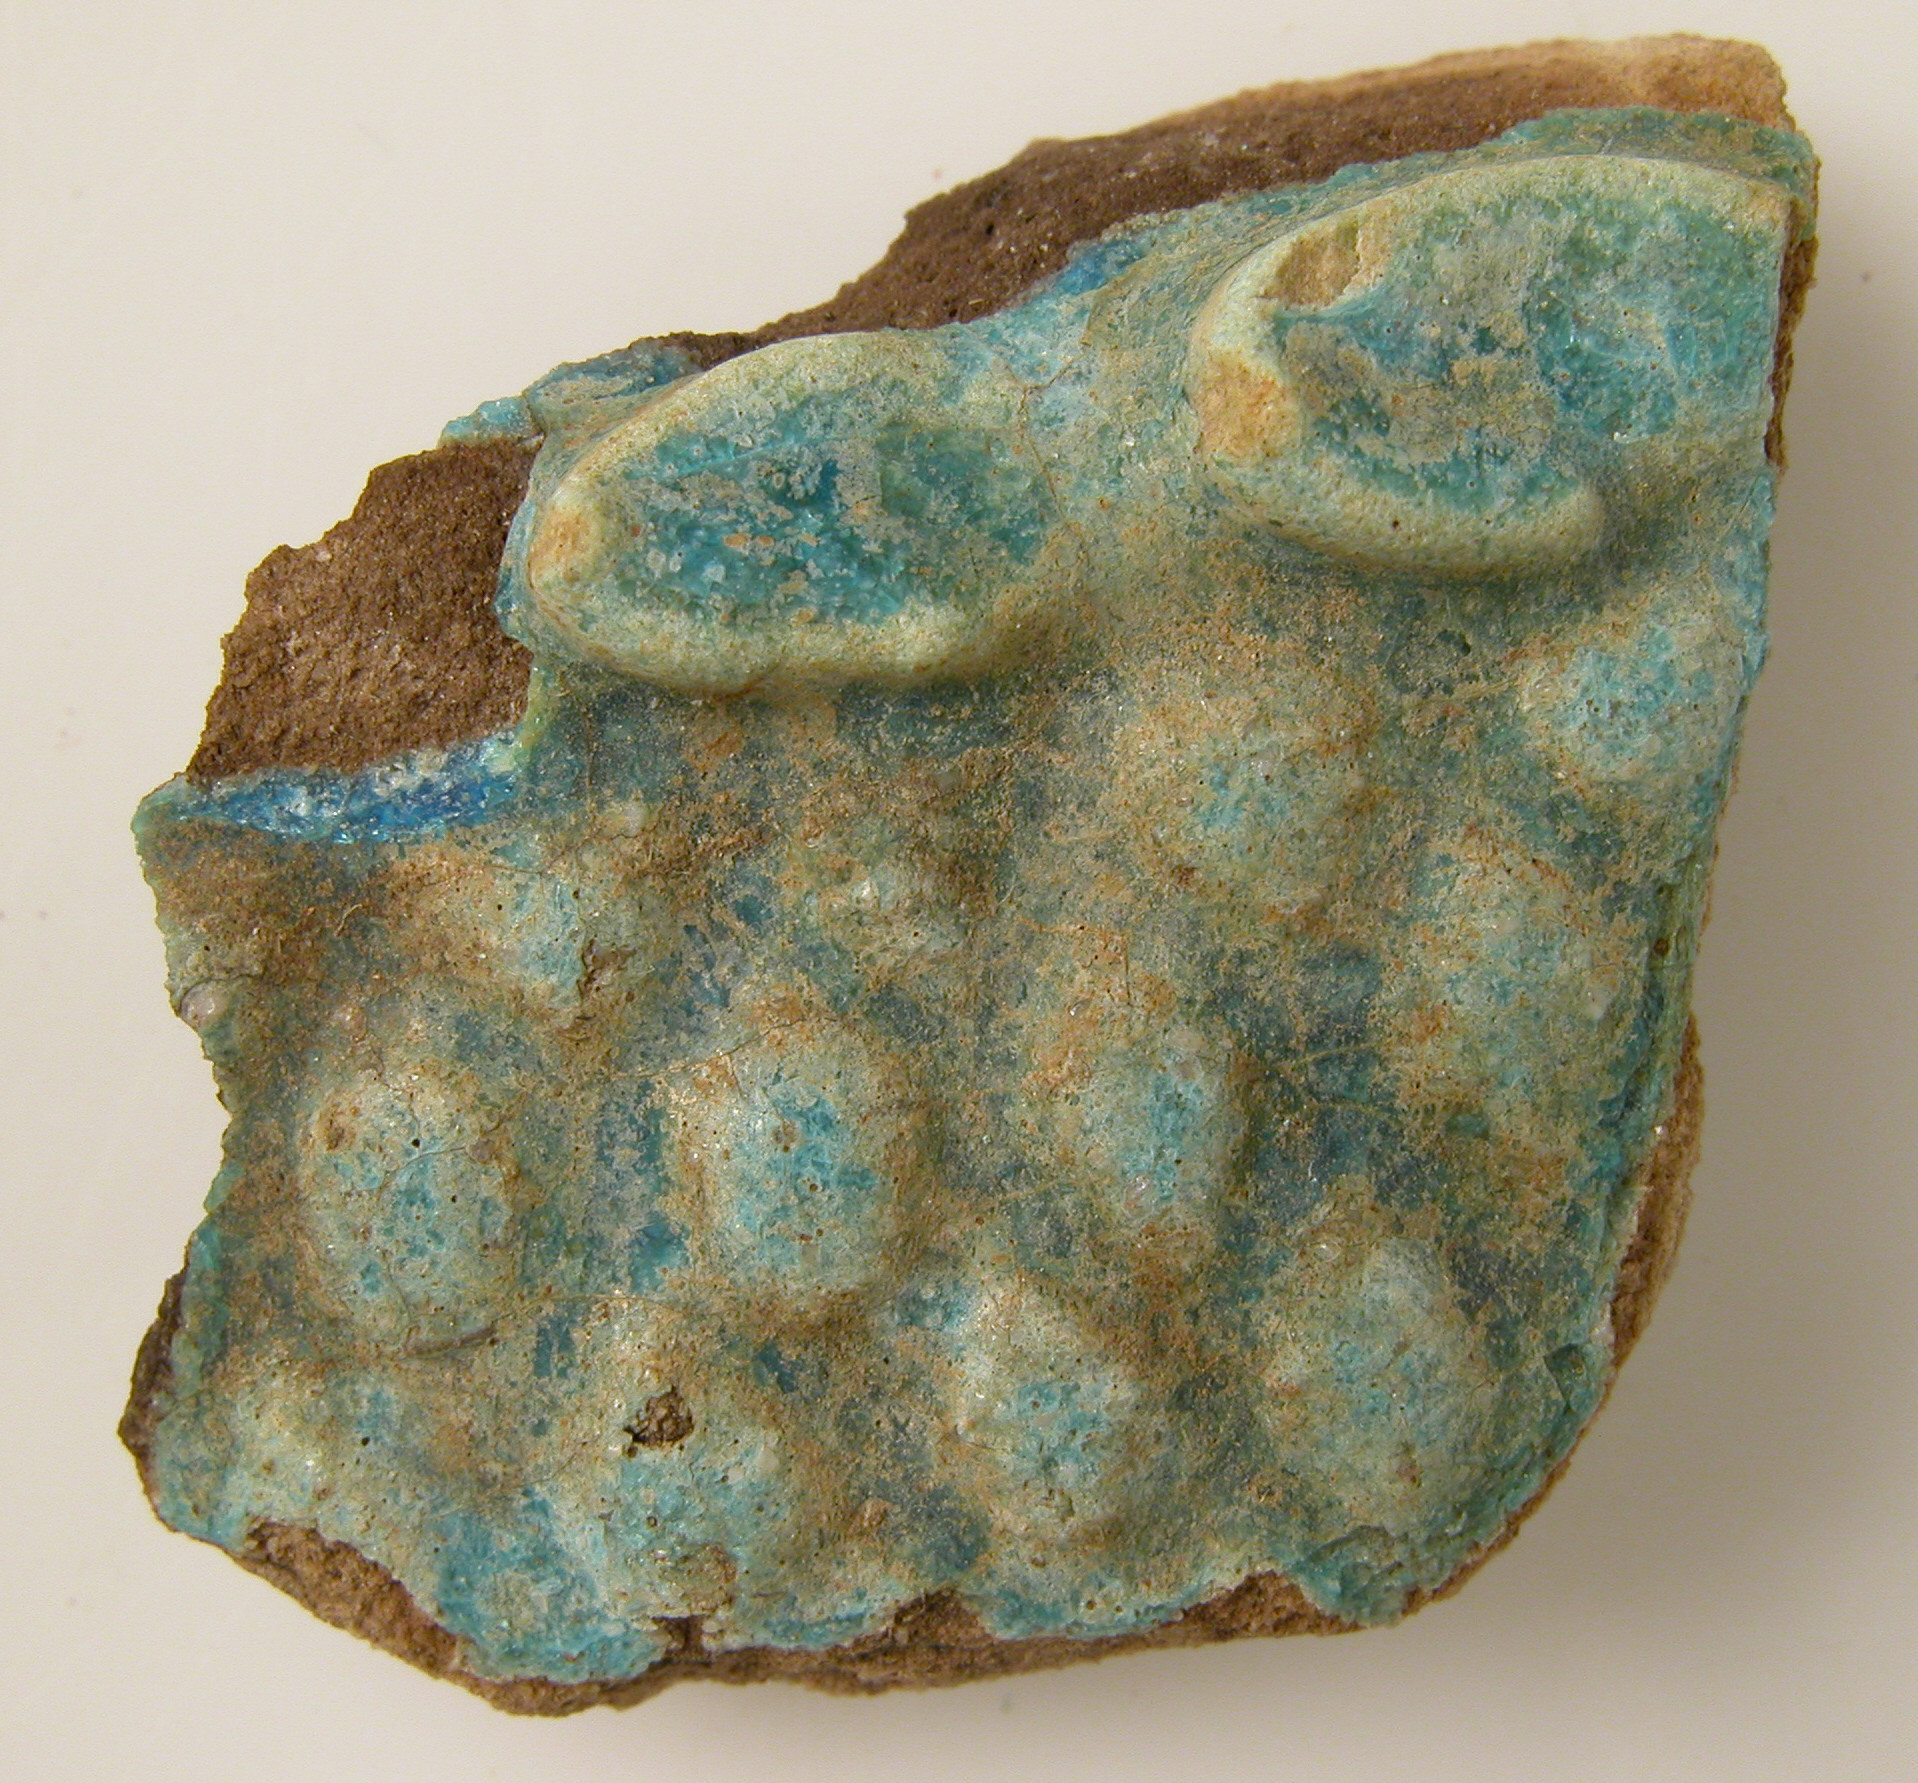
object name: fragment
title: Pottery Fragment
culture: coptic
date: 301-700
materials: earthenware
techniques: glazing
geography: egypt